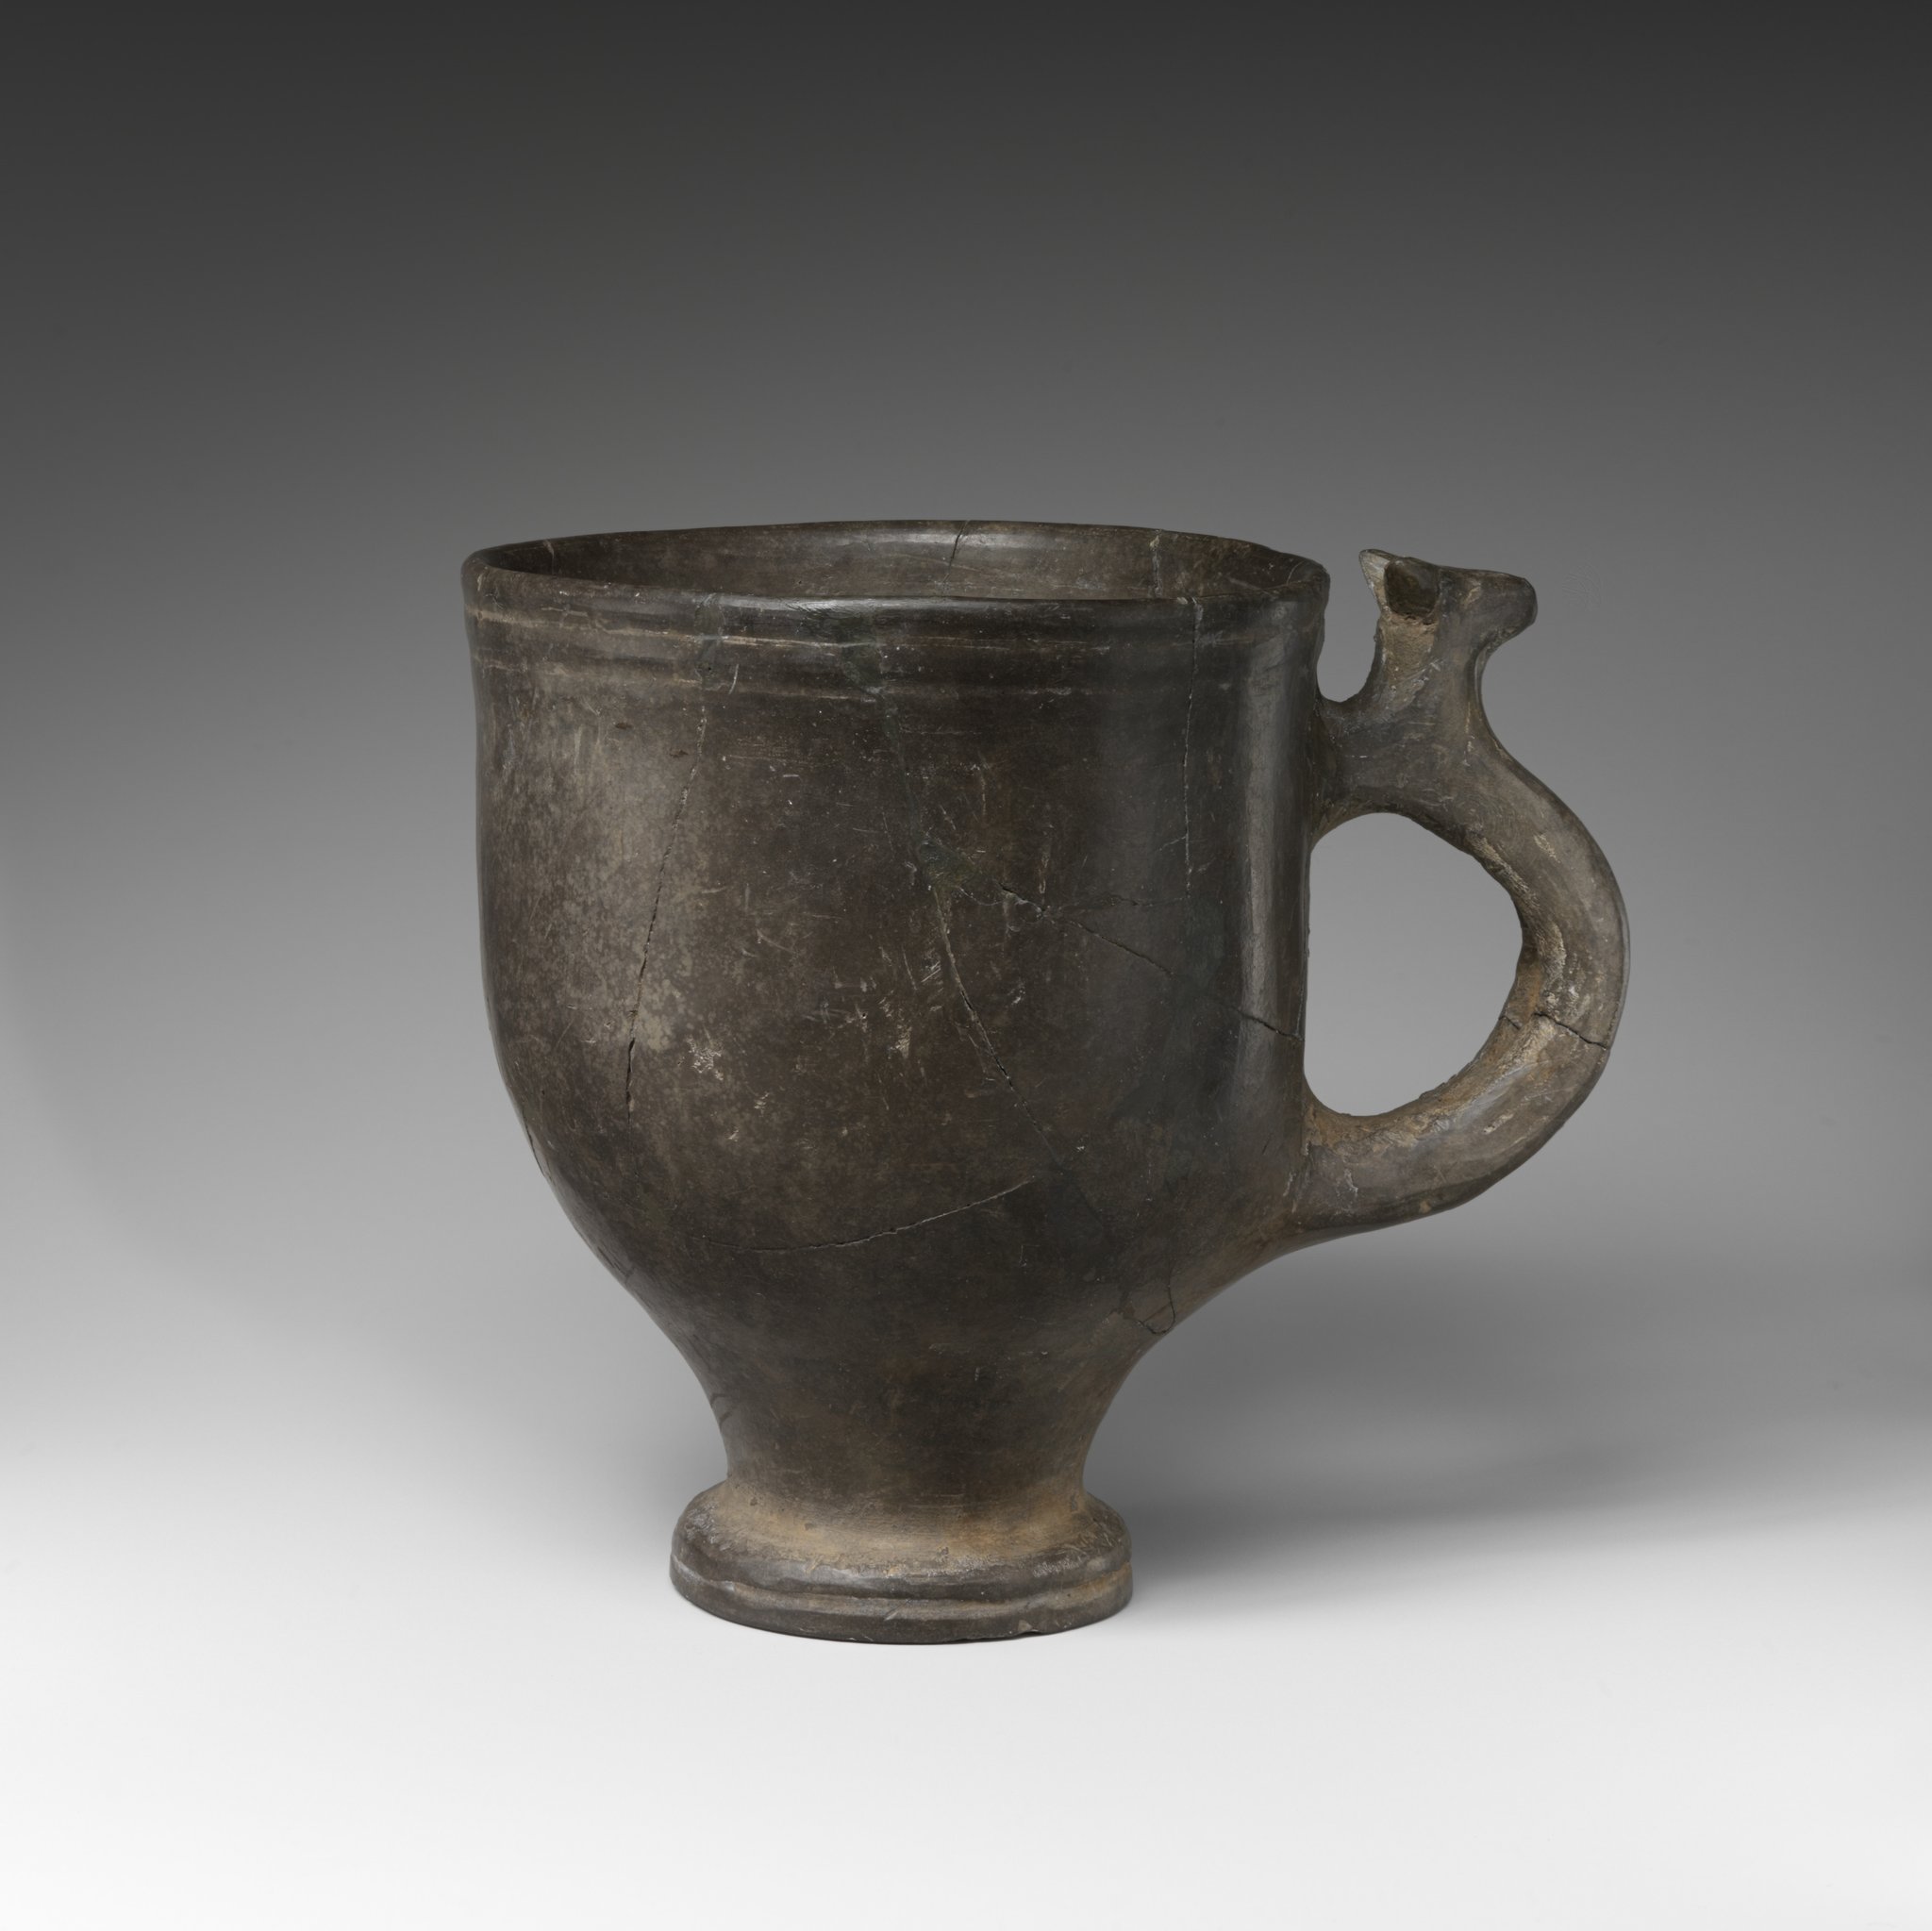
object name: goblet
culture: iranian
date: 900-801 BCE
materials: ceramic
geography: iran